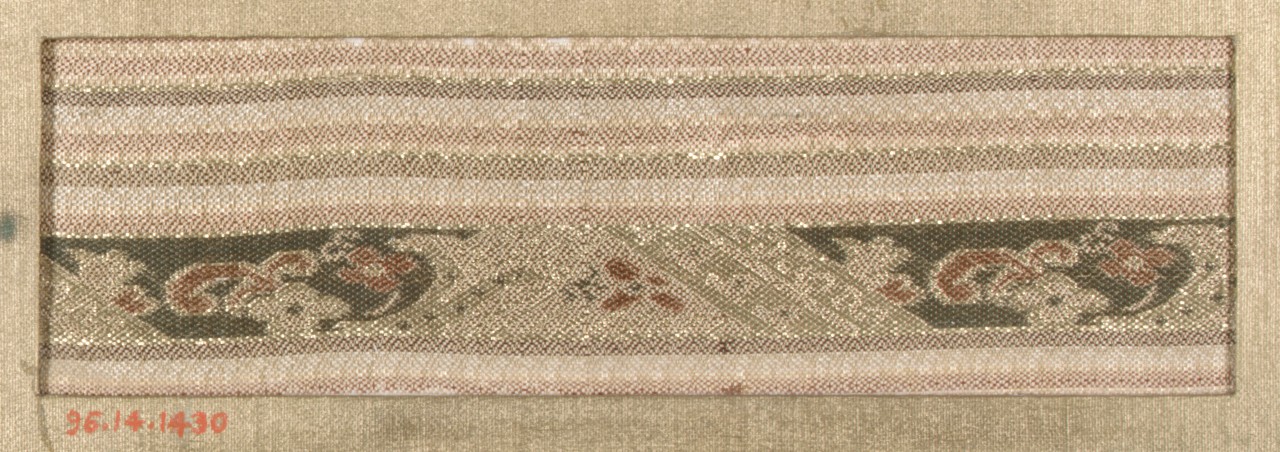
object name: piece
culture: japanese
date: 1701-1900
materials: silk